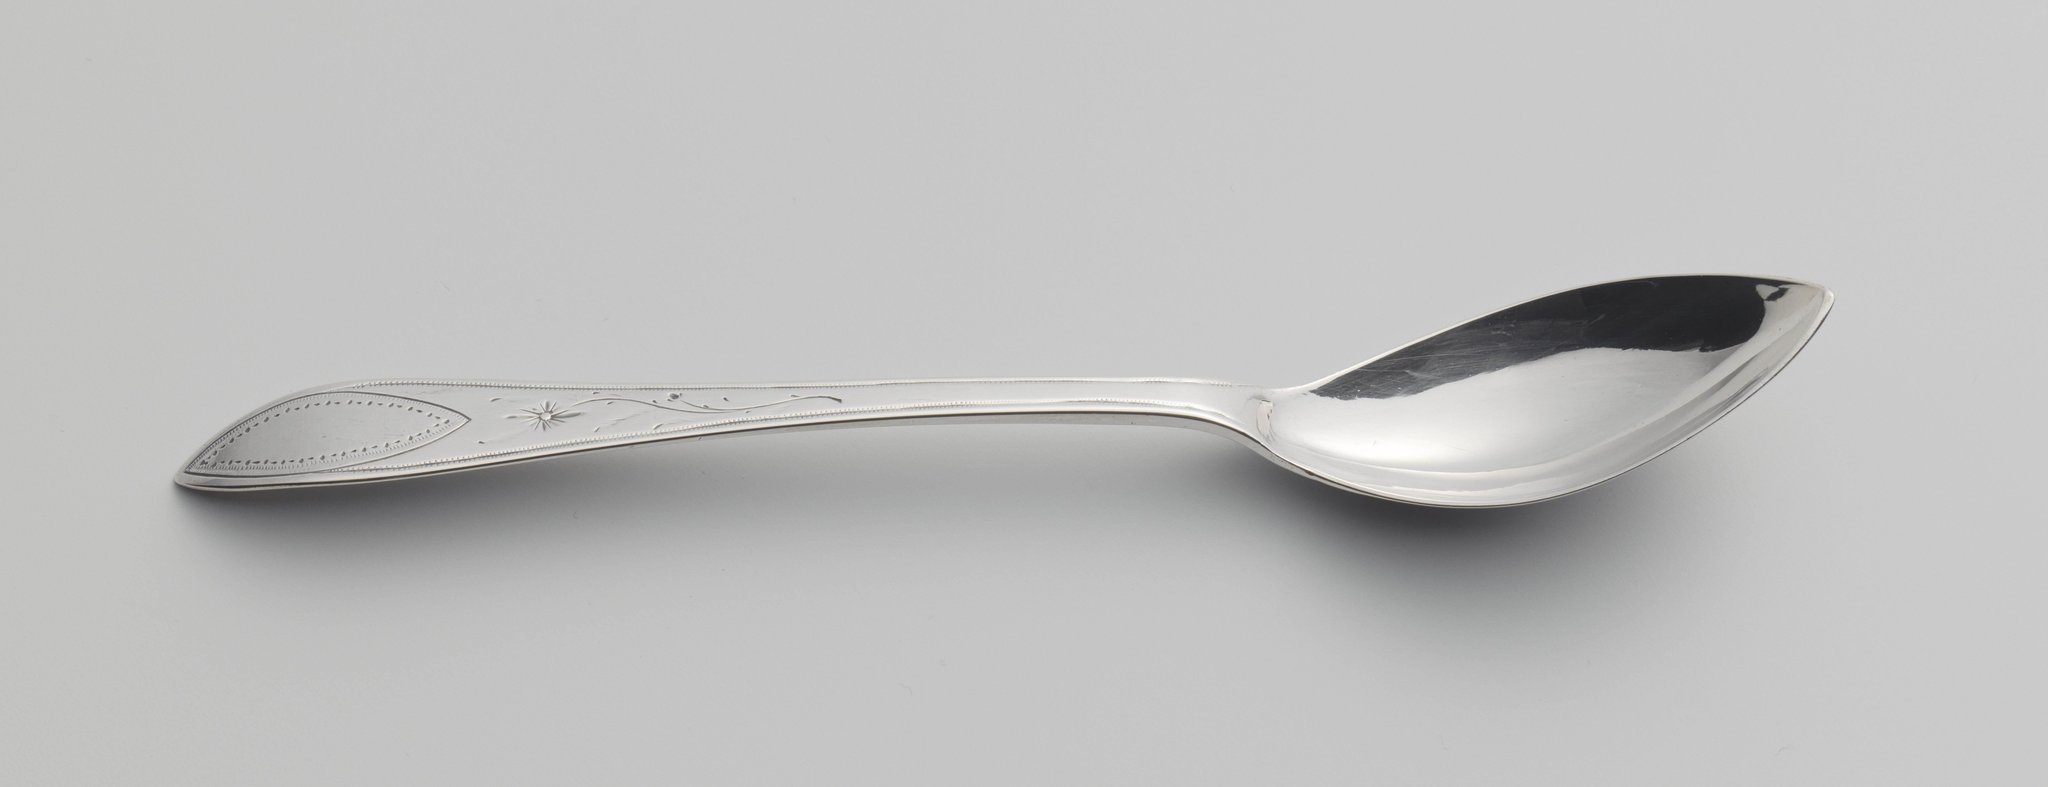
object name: teaspoon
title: Lepel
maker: cornelis knuysting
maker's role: silversmith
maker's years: 1730-1812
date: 1802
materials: silver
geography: rotterdam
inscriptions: mark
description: Lepel van zilver, met spits ovale bak en spits toelopende steel. De steel is aan de bovenzijde gegraveerd met een bloemrank en een ovaal medaillon.